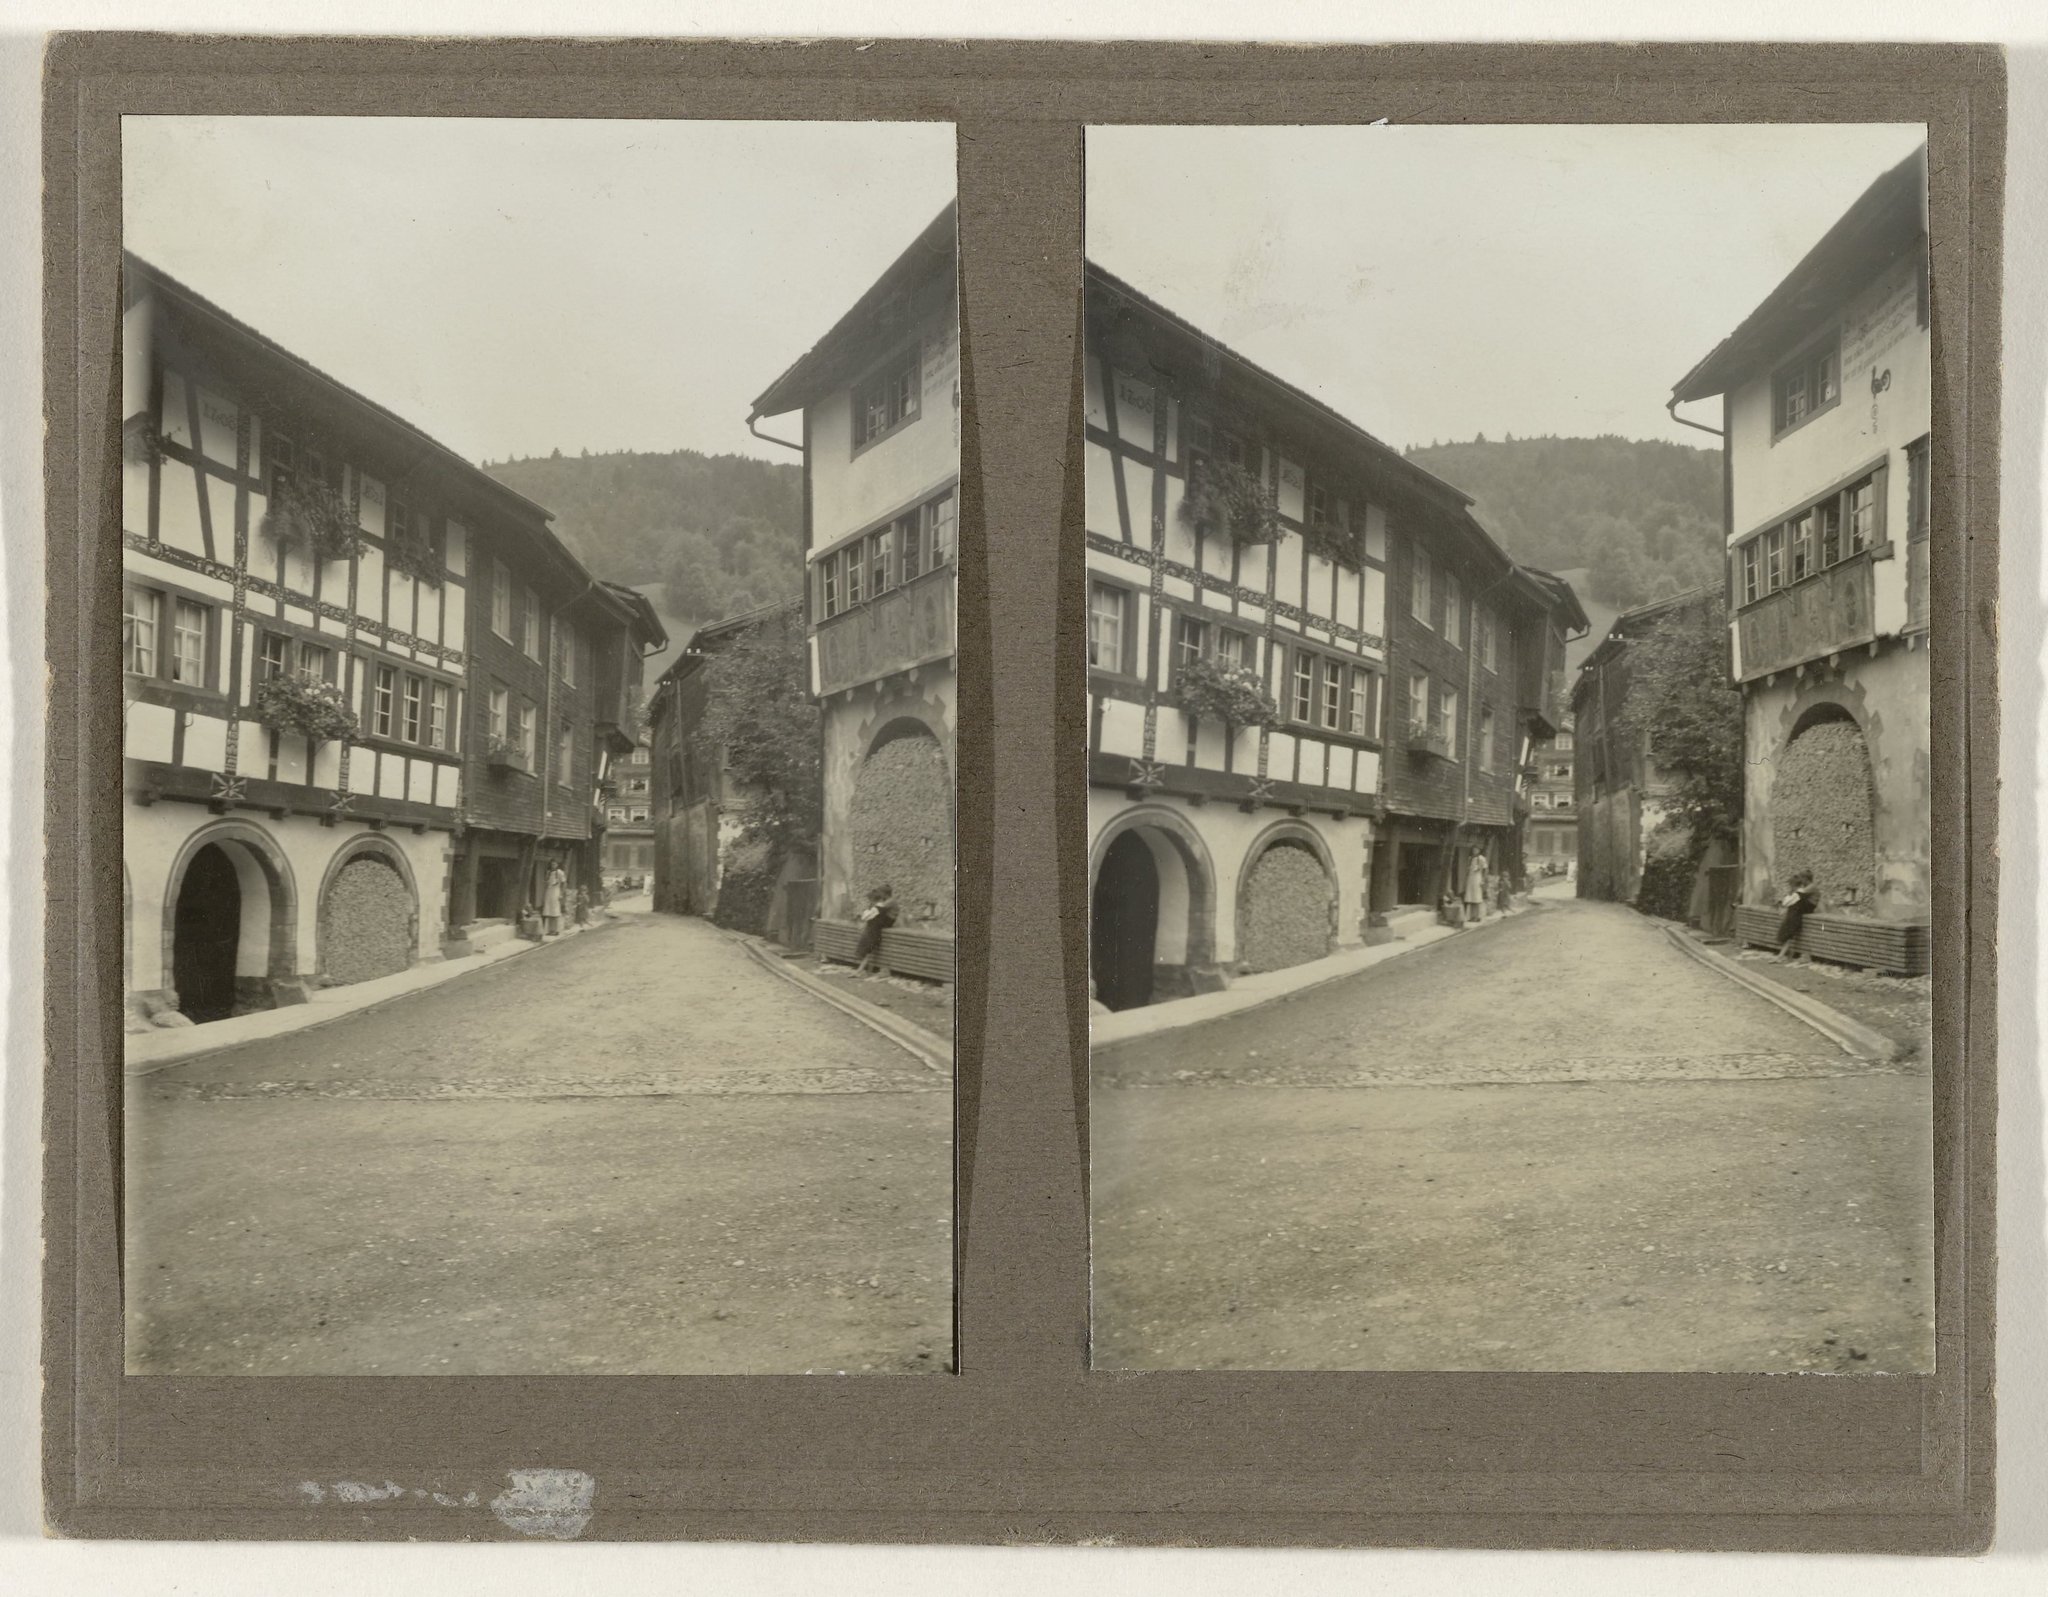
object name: stereograph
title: Straatgezicht in een heuvelachtig landschap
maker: geldolph adriaan kessler (dolph)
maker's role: fotograaf, industrieel, voetballer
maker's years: 1884-1945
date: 1895-1903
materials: paper, photographic support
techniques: collodion silver print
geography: netherlands